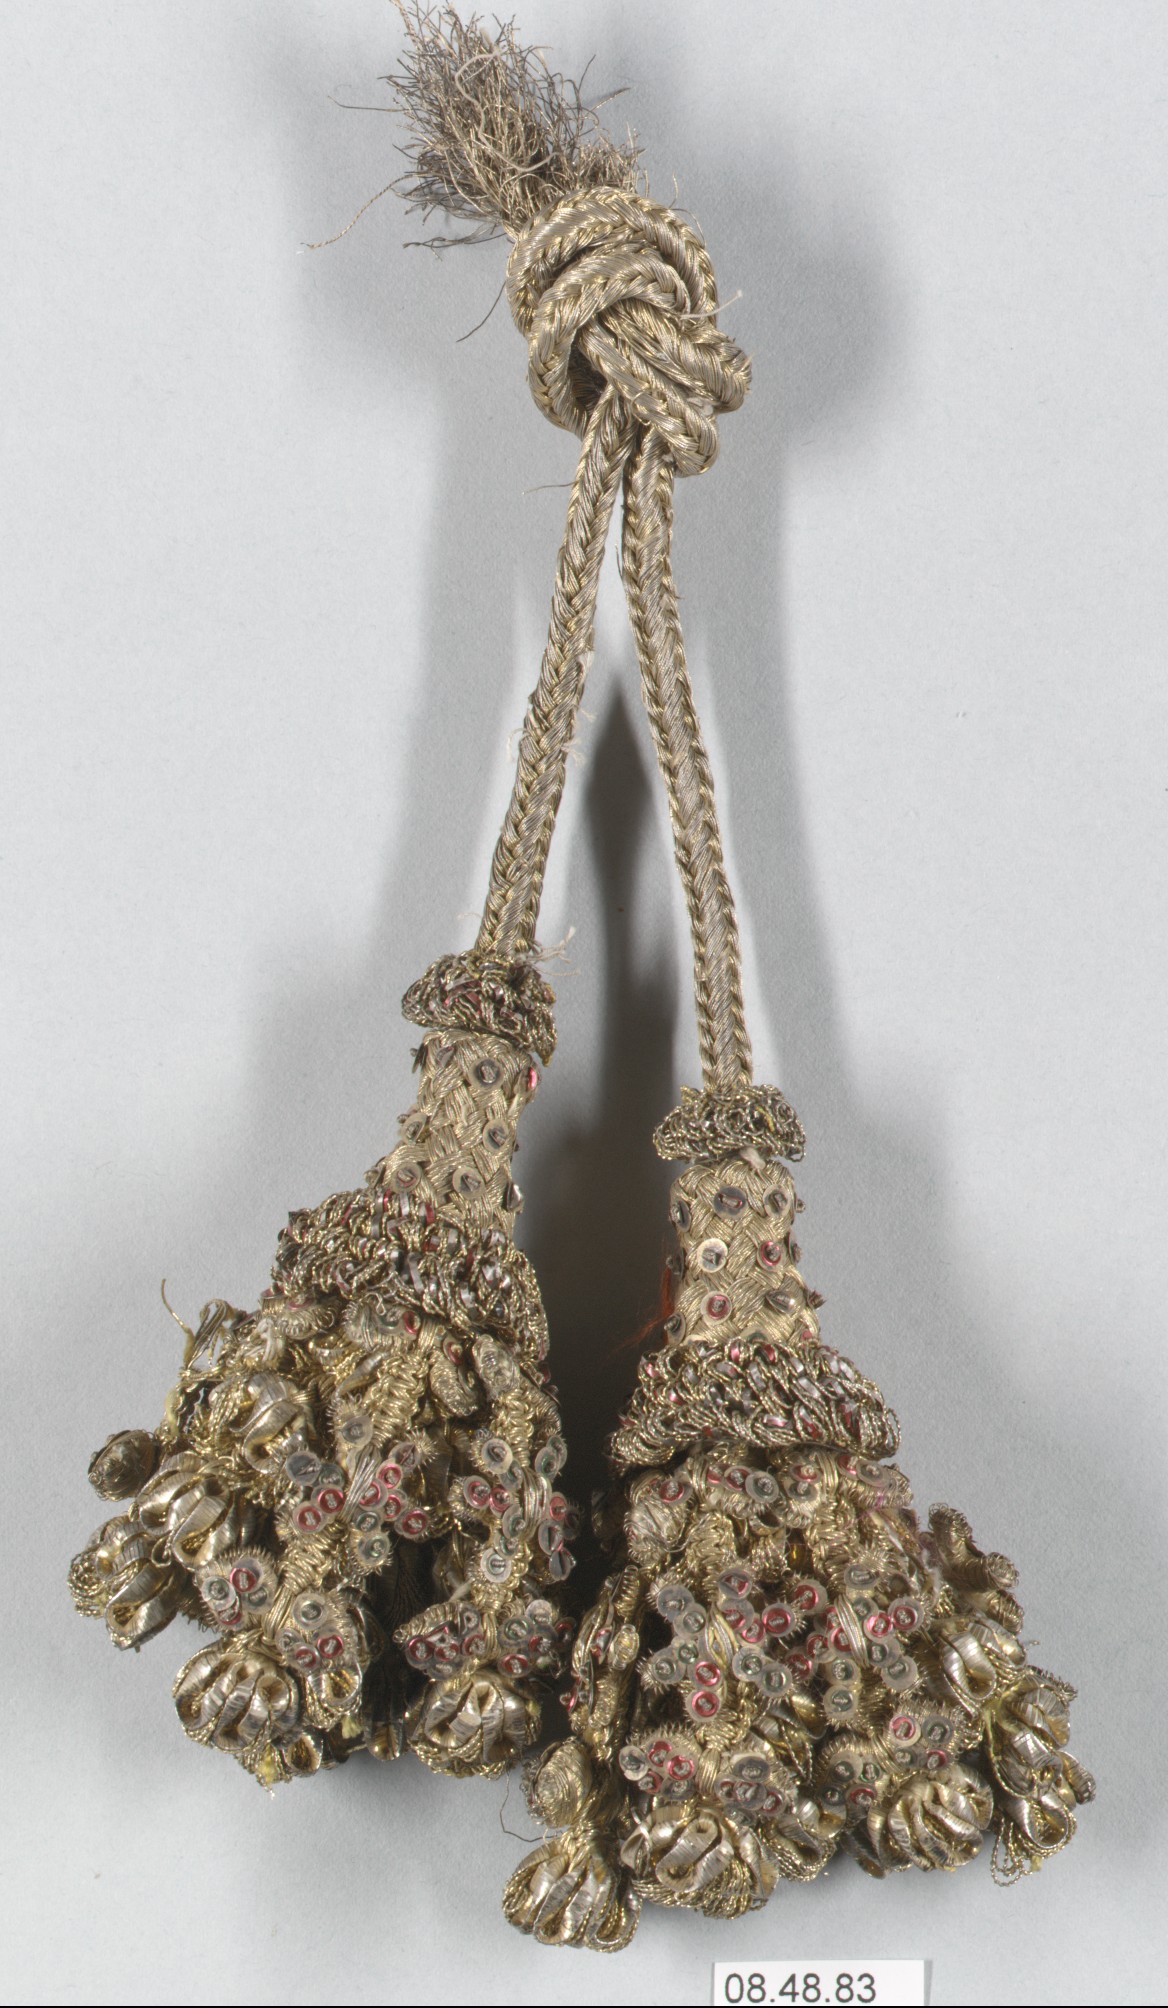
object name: tassel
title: Pair of tassels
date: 1501-1600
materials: metal thread